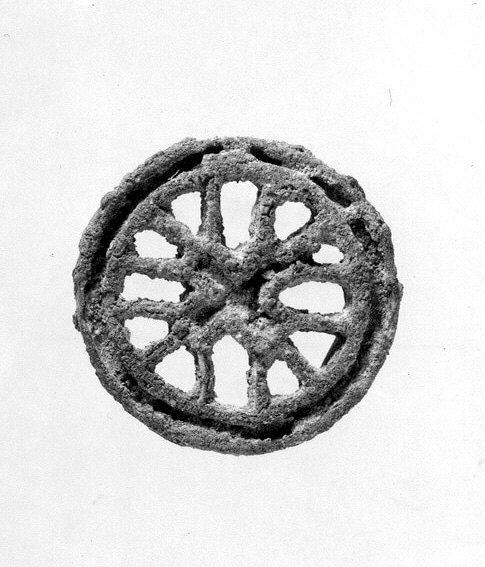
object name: stamp seal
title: Compartmented stamp seal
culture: bactria-margiana archaeological complex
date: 2333-1668 BCE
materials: copper alloy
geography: bactria-margiana